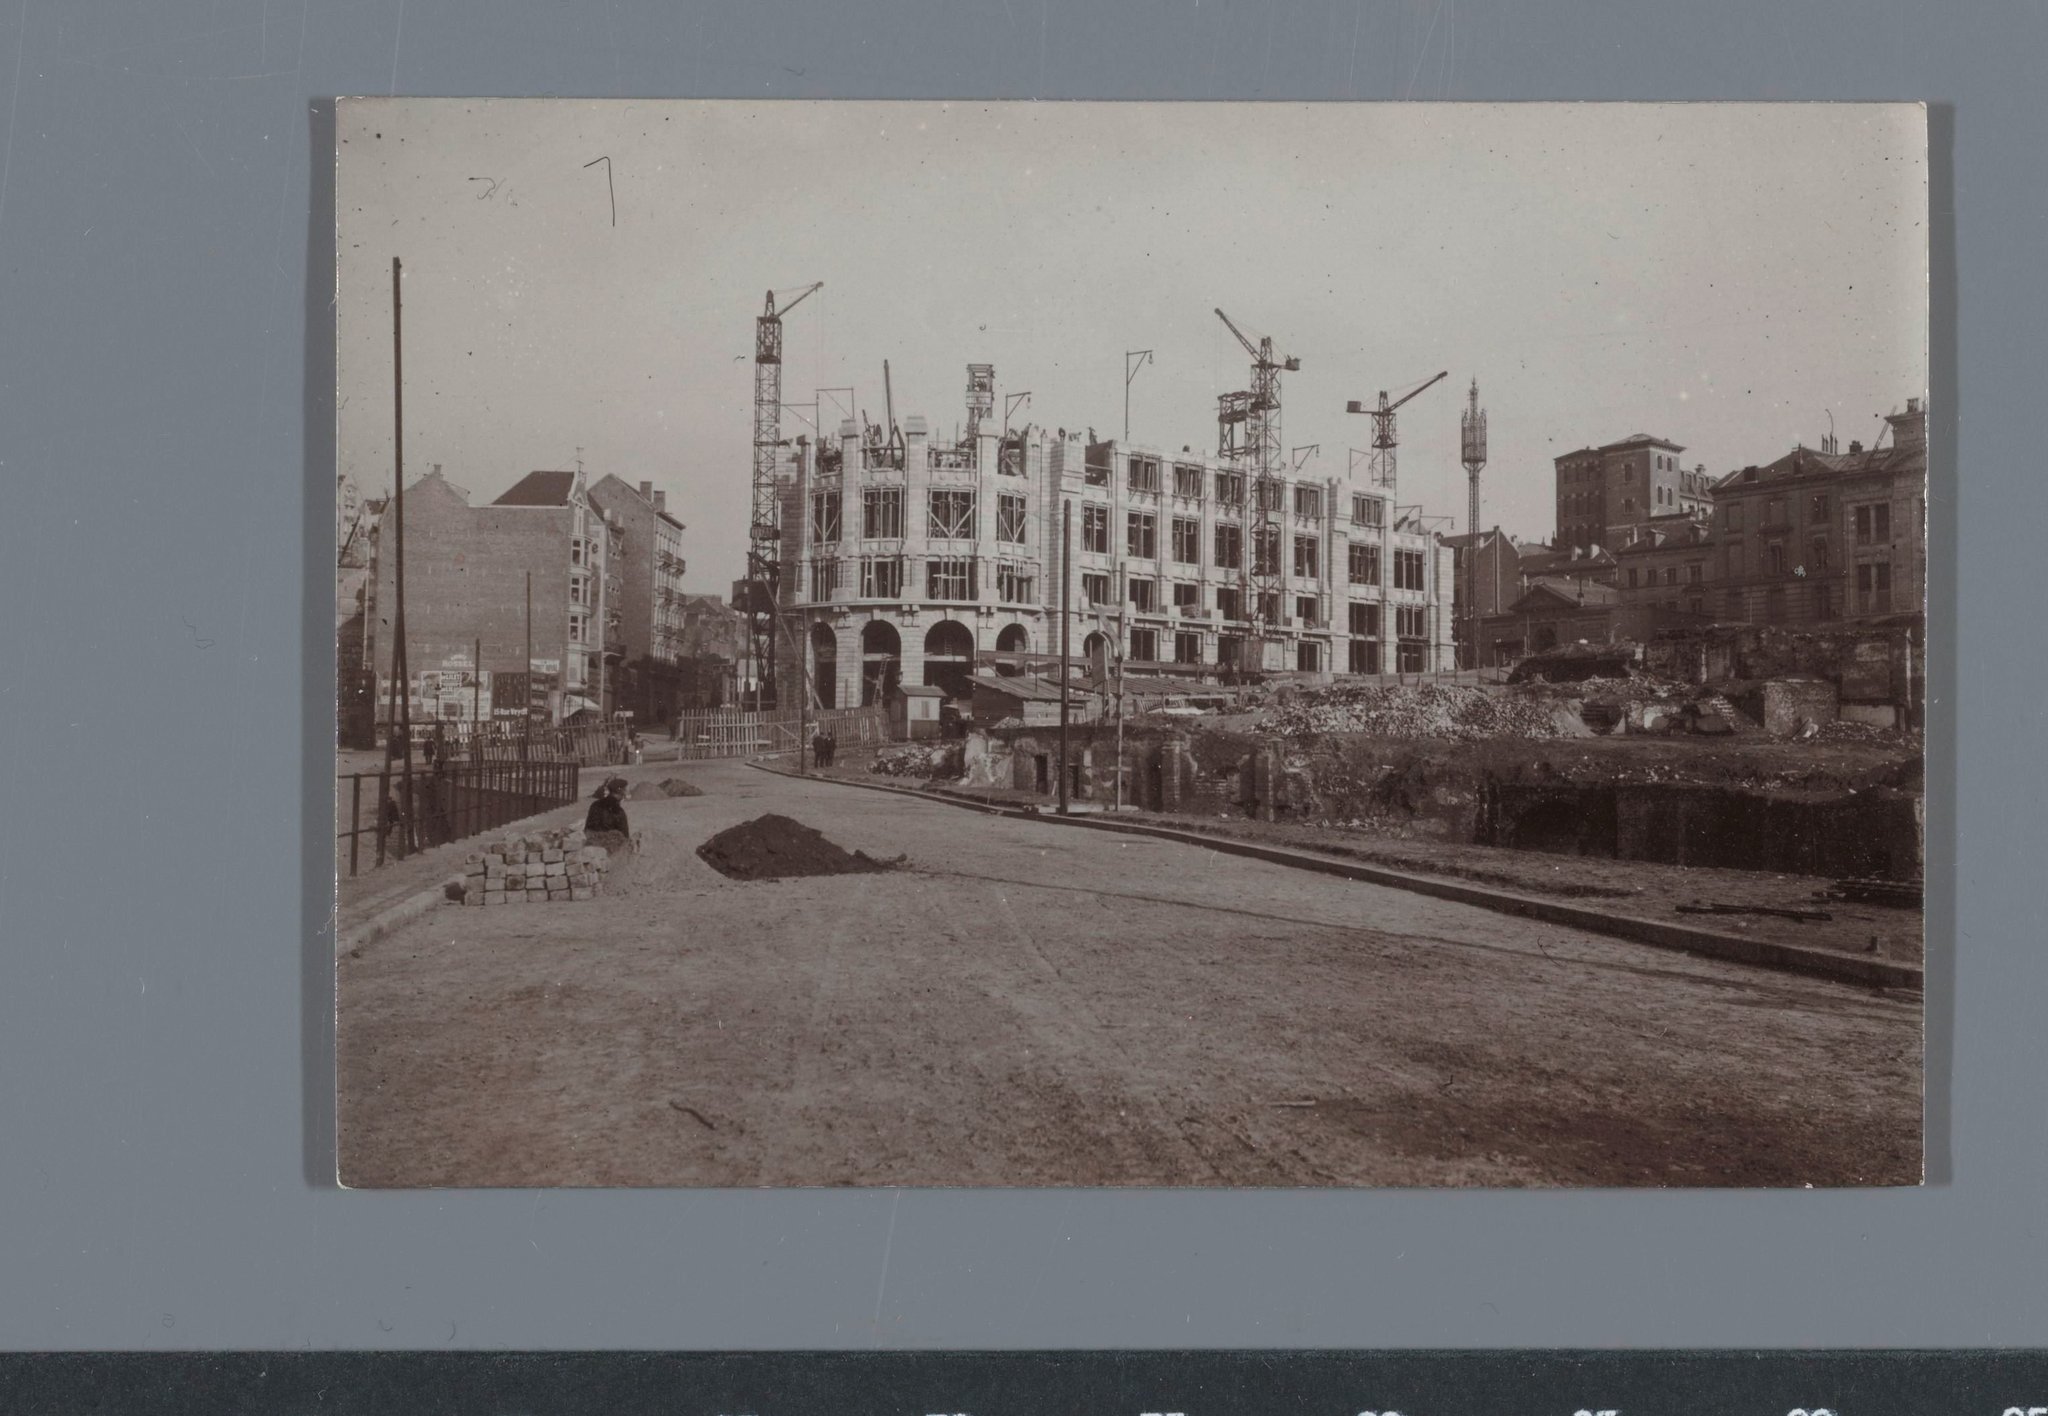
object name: photograph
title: Bouwwerkzaamheden in Brussel, België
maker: wesseling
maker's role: fotograaf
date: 1912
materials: photographic support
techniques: gelatin silver print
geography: brussels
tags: building-site, brussels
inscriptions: signature and date: ‘11/2 1912 / Wesseling’, inscription: ‘Brussel’